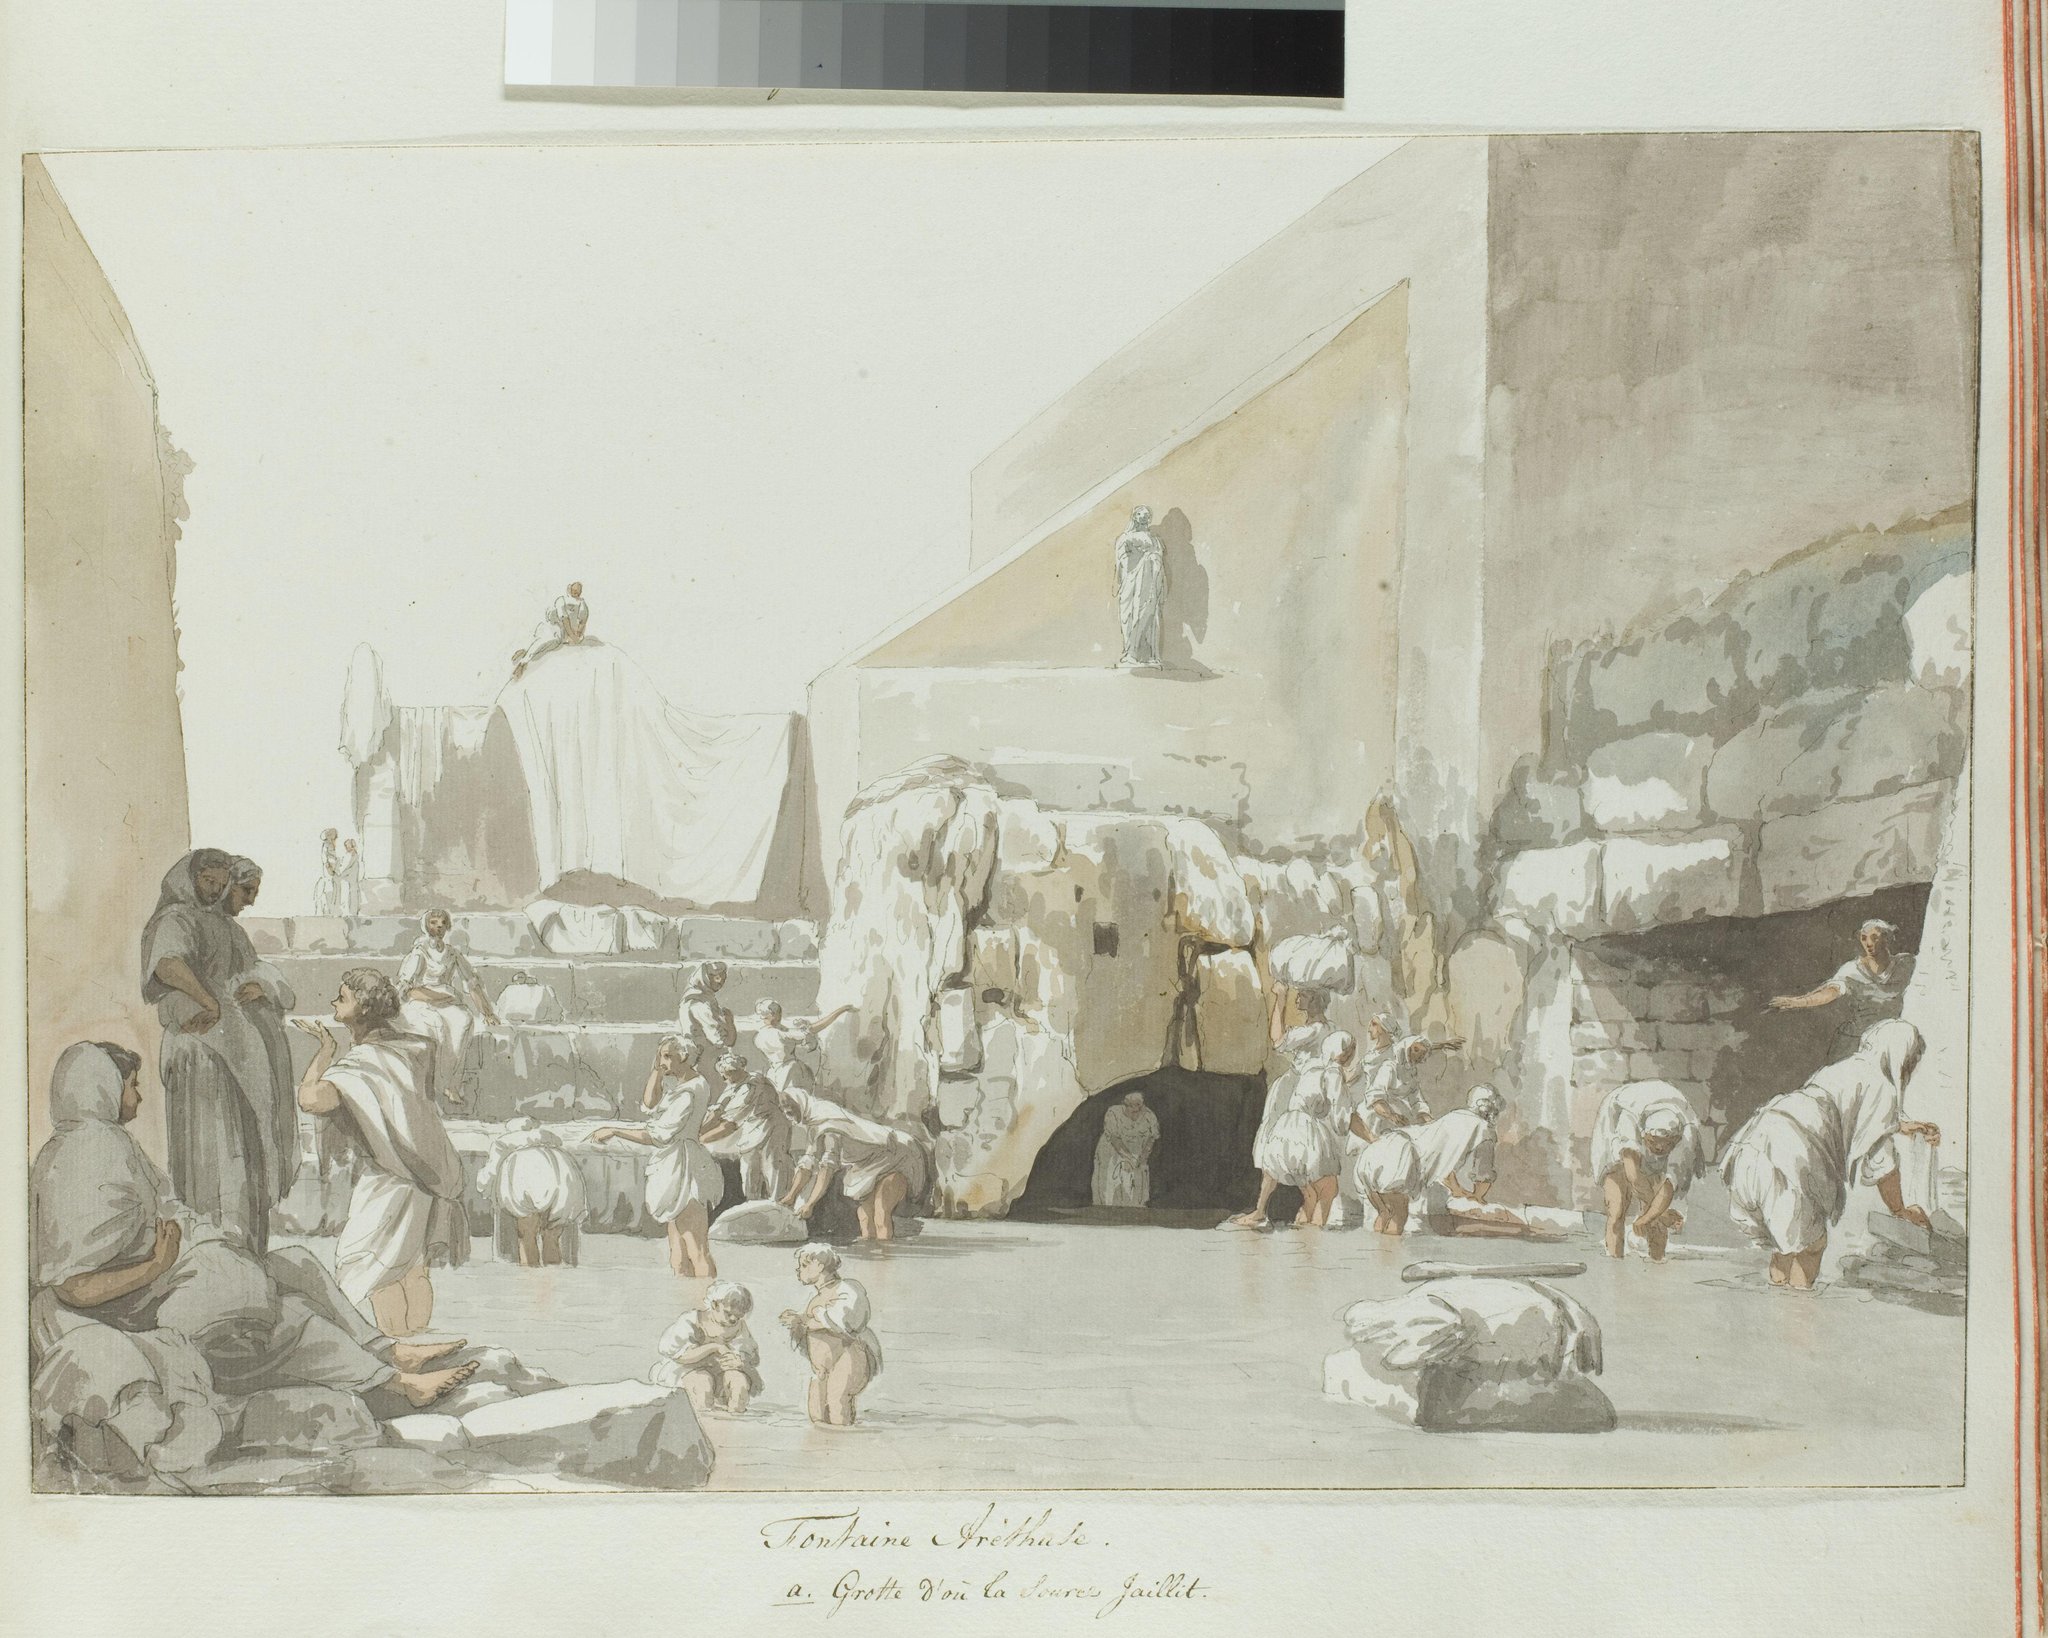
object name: watercolor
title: Fontaine Aréthuse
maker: louis ducros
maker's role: draughtsman, print maker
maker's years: 1748-1810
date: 1778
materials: chalk, paper, watercolor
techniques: brush, pen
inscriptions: inscription: ‘No 195 Fontaine Aréthuse’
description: Tekening uit het album 'Voyage en Italie, en Sicile et à Malte', 1778.